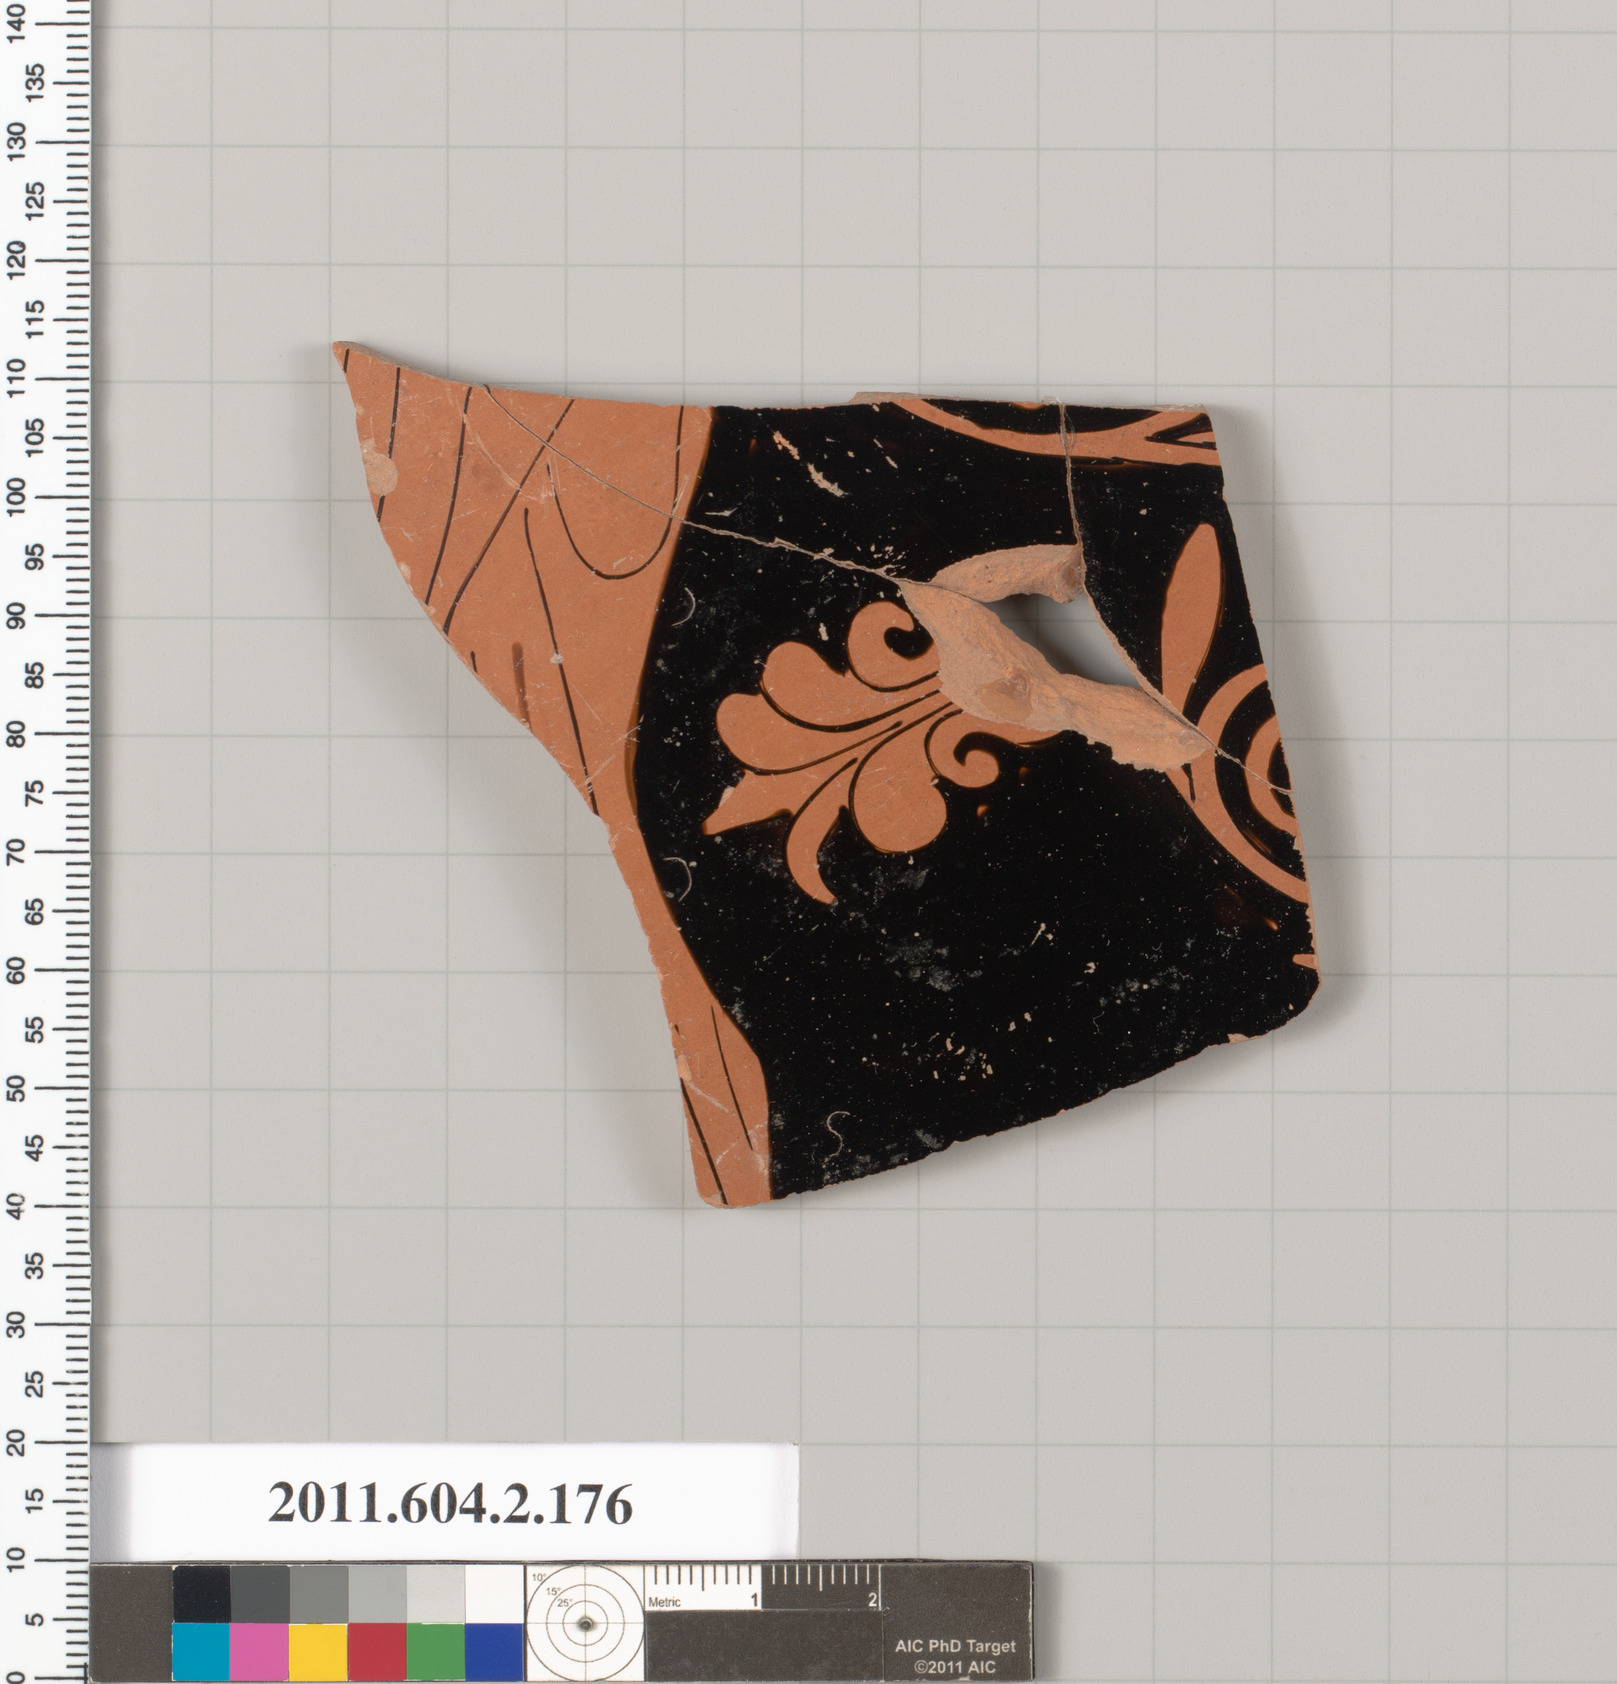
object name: stamnos fragment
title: Terracotta fragment of a stamnos (jar)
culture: greek, attic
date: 490-470 BCE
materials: terracotta